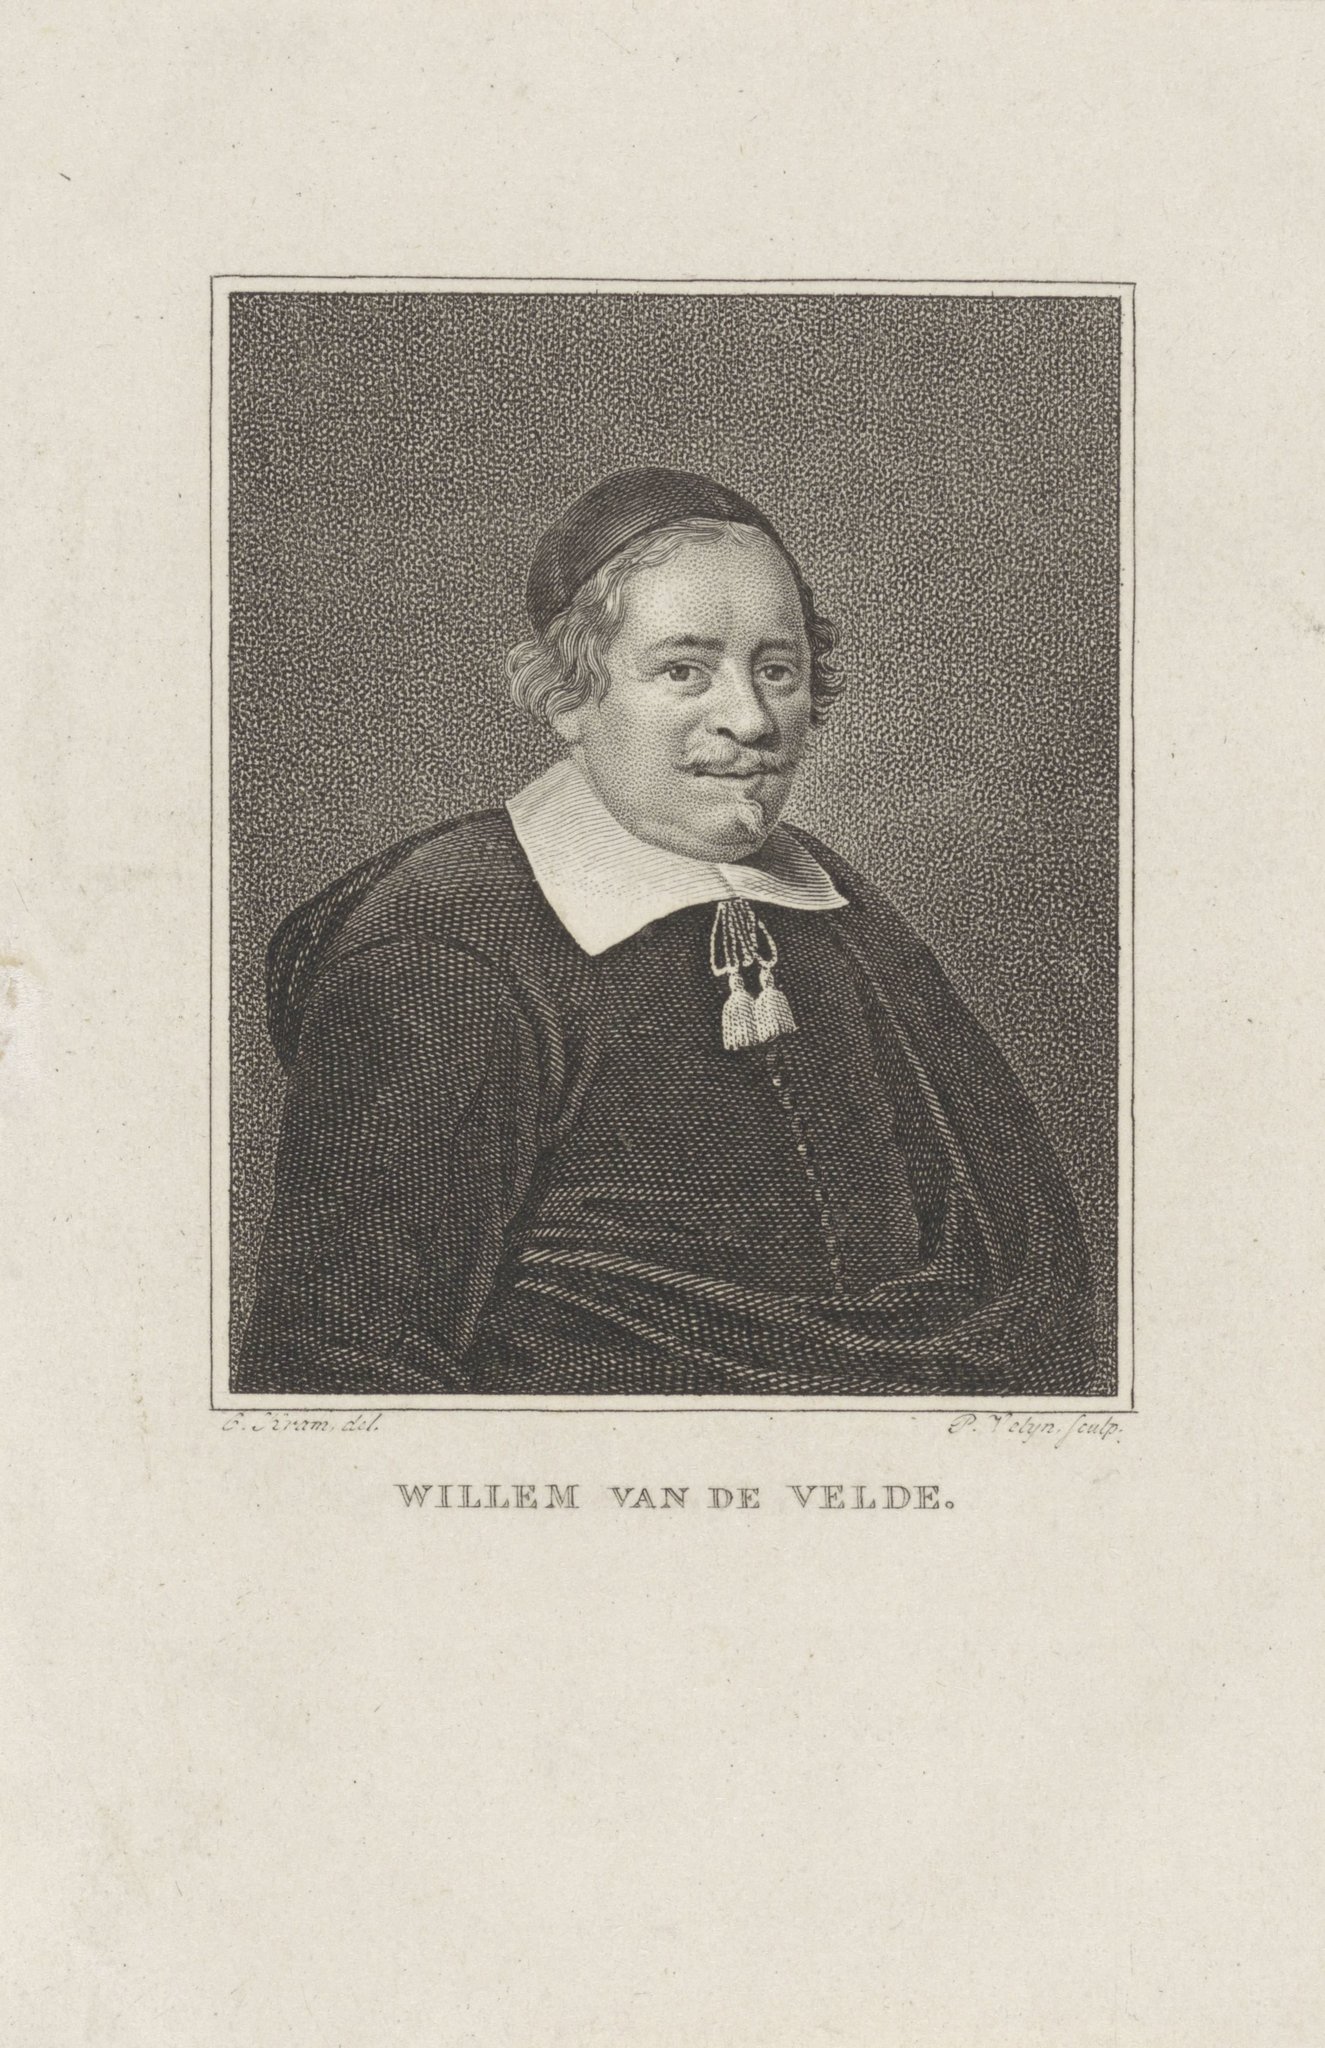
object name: print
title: Portret van Willem Cornelissen van Velden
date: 1797-1836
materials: paper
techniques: engraving, etching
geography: netherlands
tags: advocaat, dichter, willem cornelisz. van velden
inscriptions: collector's mark: Lugt 2228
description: Portret van vermoedelijk Willem Cornelisz. van Velden (1603-63). Van Velden was de vroegere dienaar van Hugo de Groot. Hij werd in 1625 beëdigd als notaris en in 1642 benoemd tot advocaat. In 1625 trouwde hij met Elsje van Houwelingen (zie RP-P-2021-6897), de dienstmeid van Maria van Reigersberch en Hugo de Groot, die een belangrijke rol had gespeeld bij De Groots ontsnapping uit Loevestein in 1621.